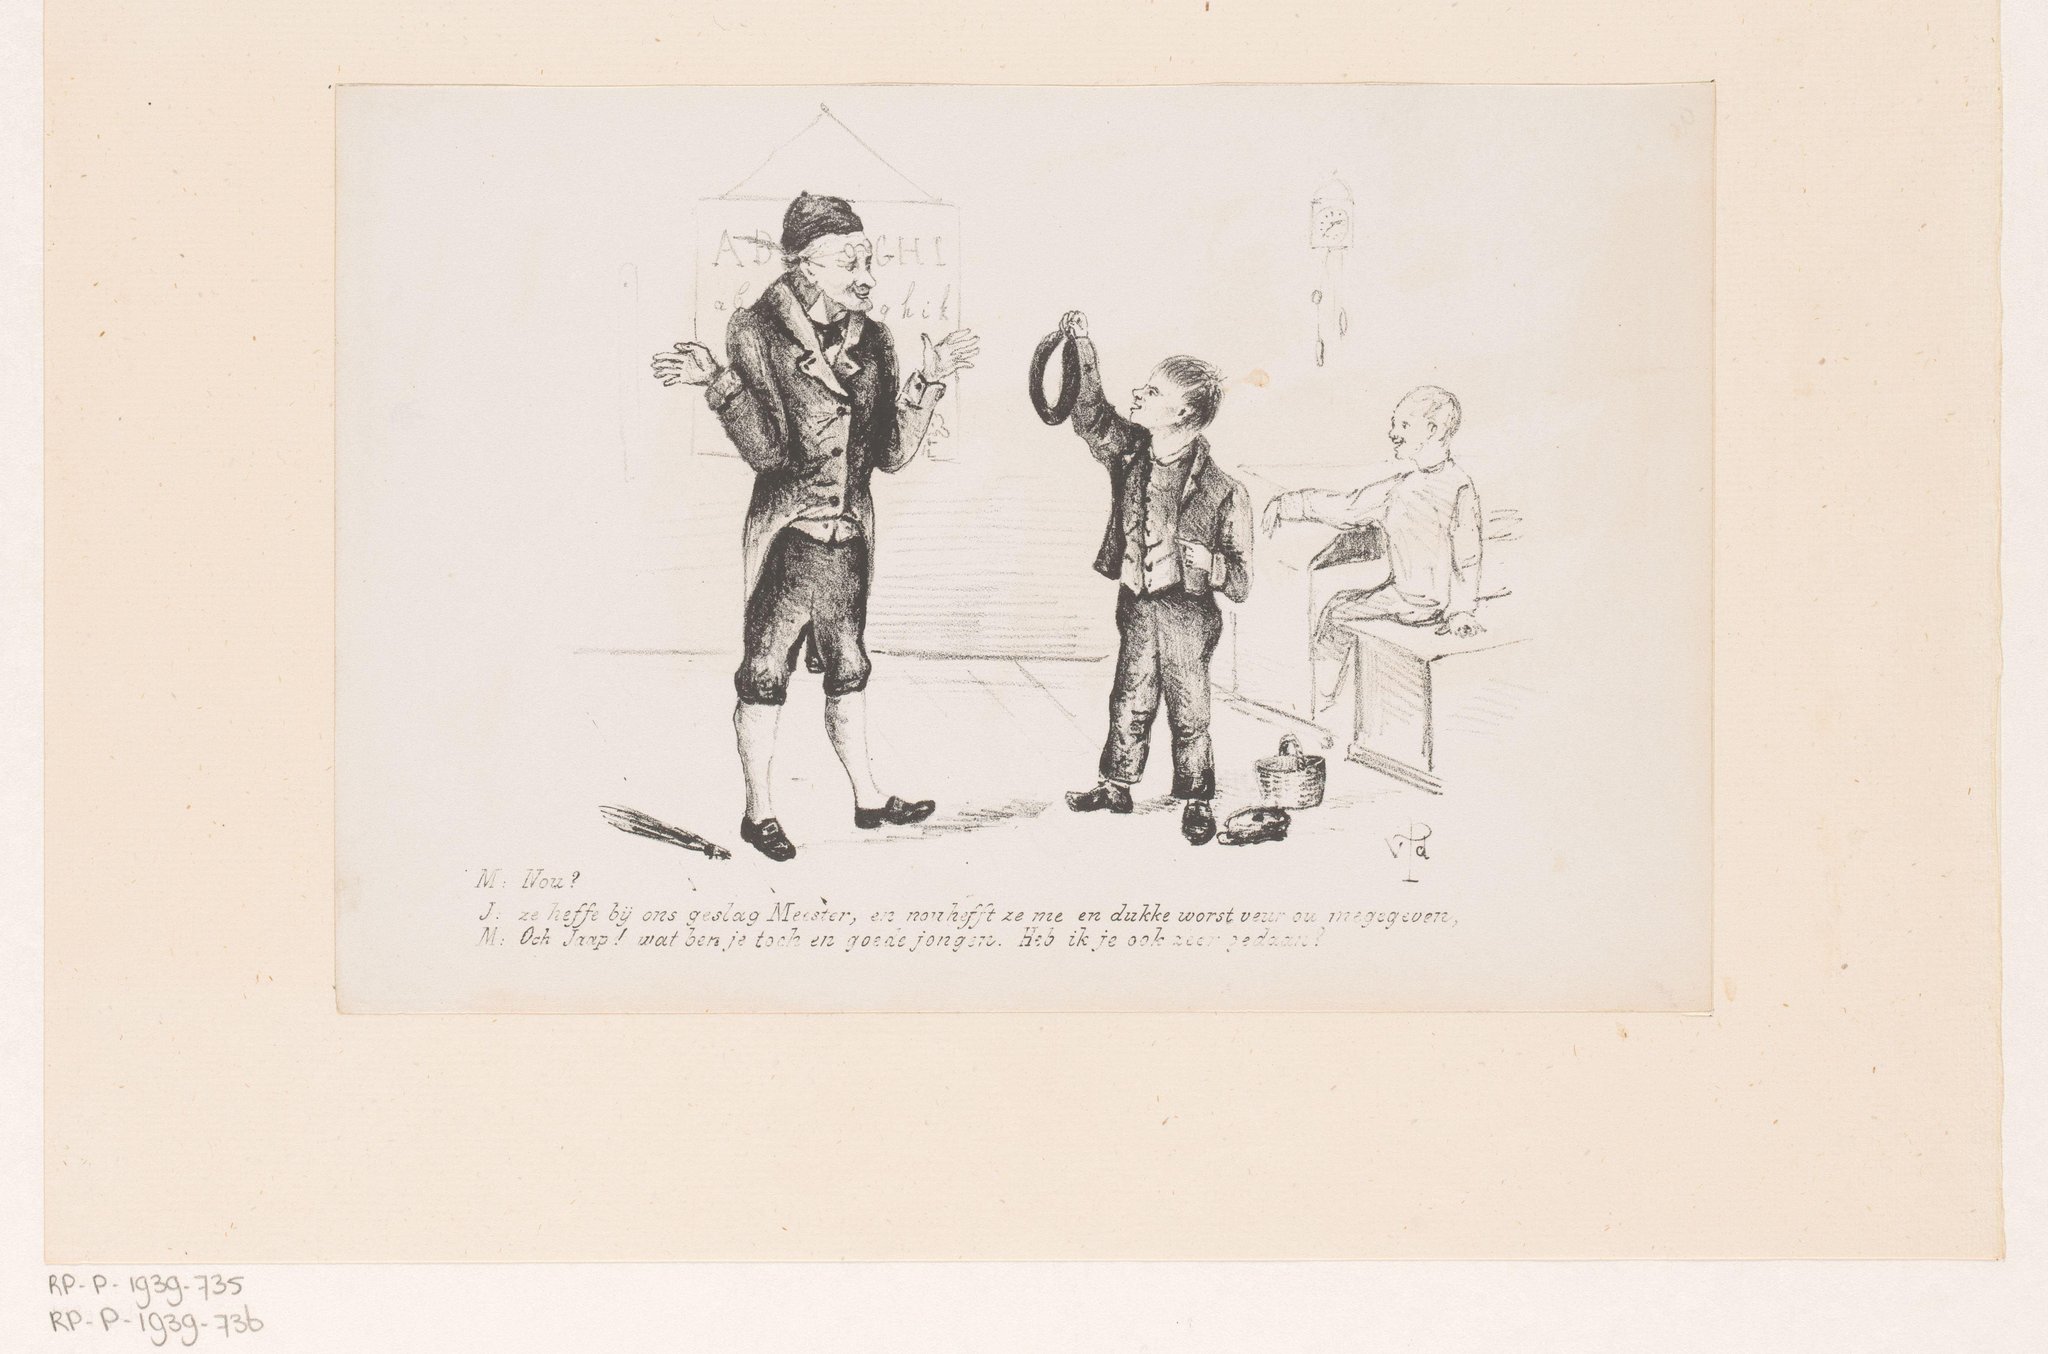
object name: print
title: Losse schetsen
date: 1864-1902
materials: paper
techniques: lithograph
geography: netherlands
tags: teacher and pupil, bribery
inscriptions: collector's mark: Lugt 2166, collector's mark: Lugt 2760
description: Een jongen koopt zijn leraar om door hem een worst aan te bieden. Rechts zit een jongen in een schoolbank.